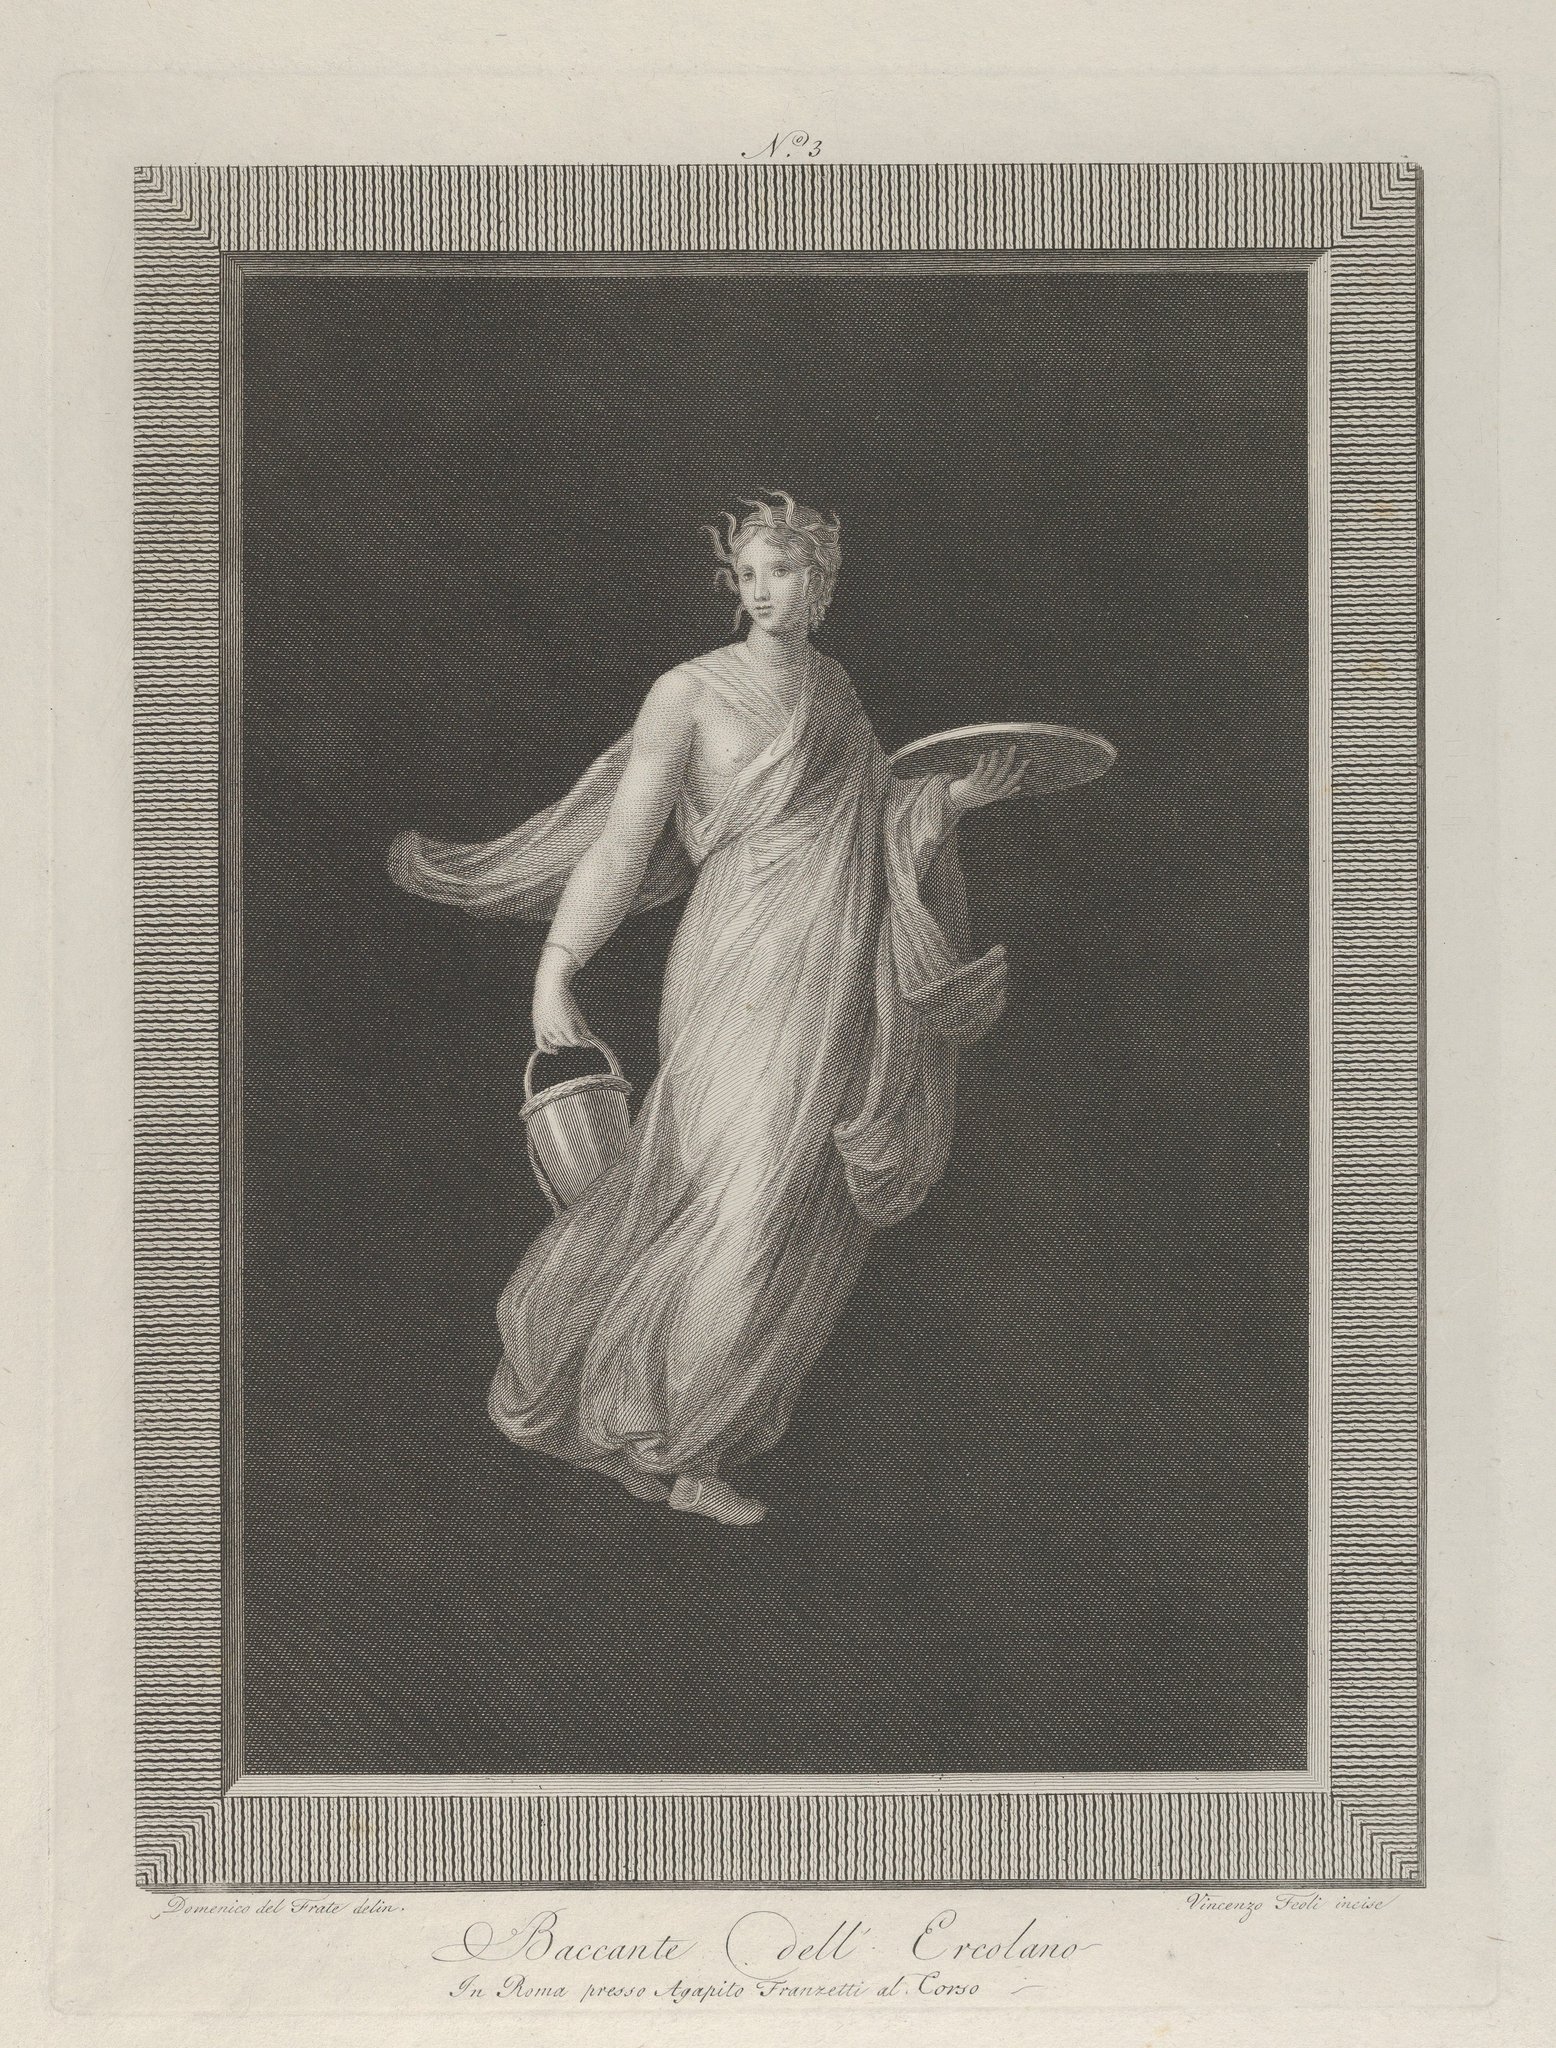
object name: print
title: A partly naked bacchante holding a disk in her raised left hand and a bucket in her right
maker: vicenzo feoli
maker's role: artist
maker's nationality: italian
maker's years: 1755-1827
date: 1795-1820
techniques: engraving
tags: bacchantes